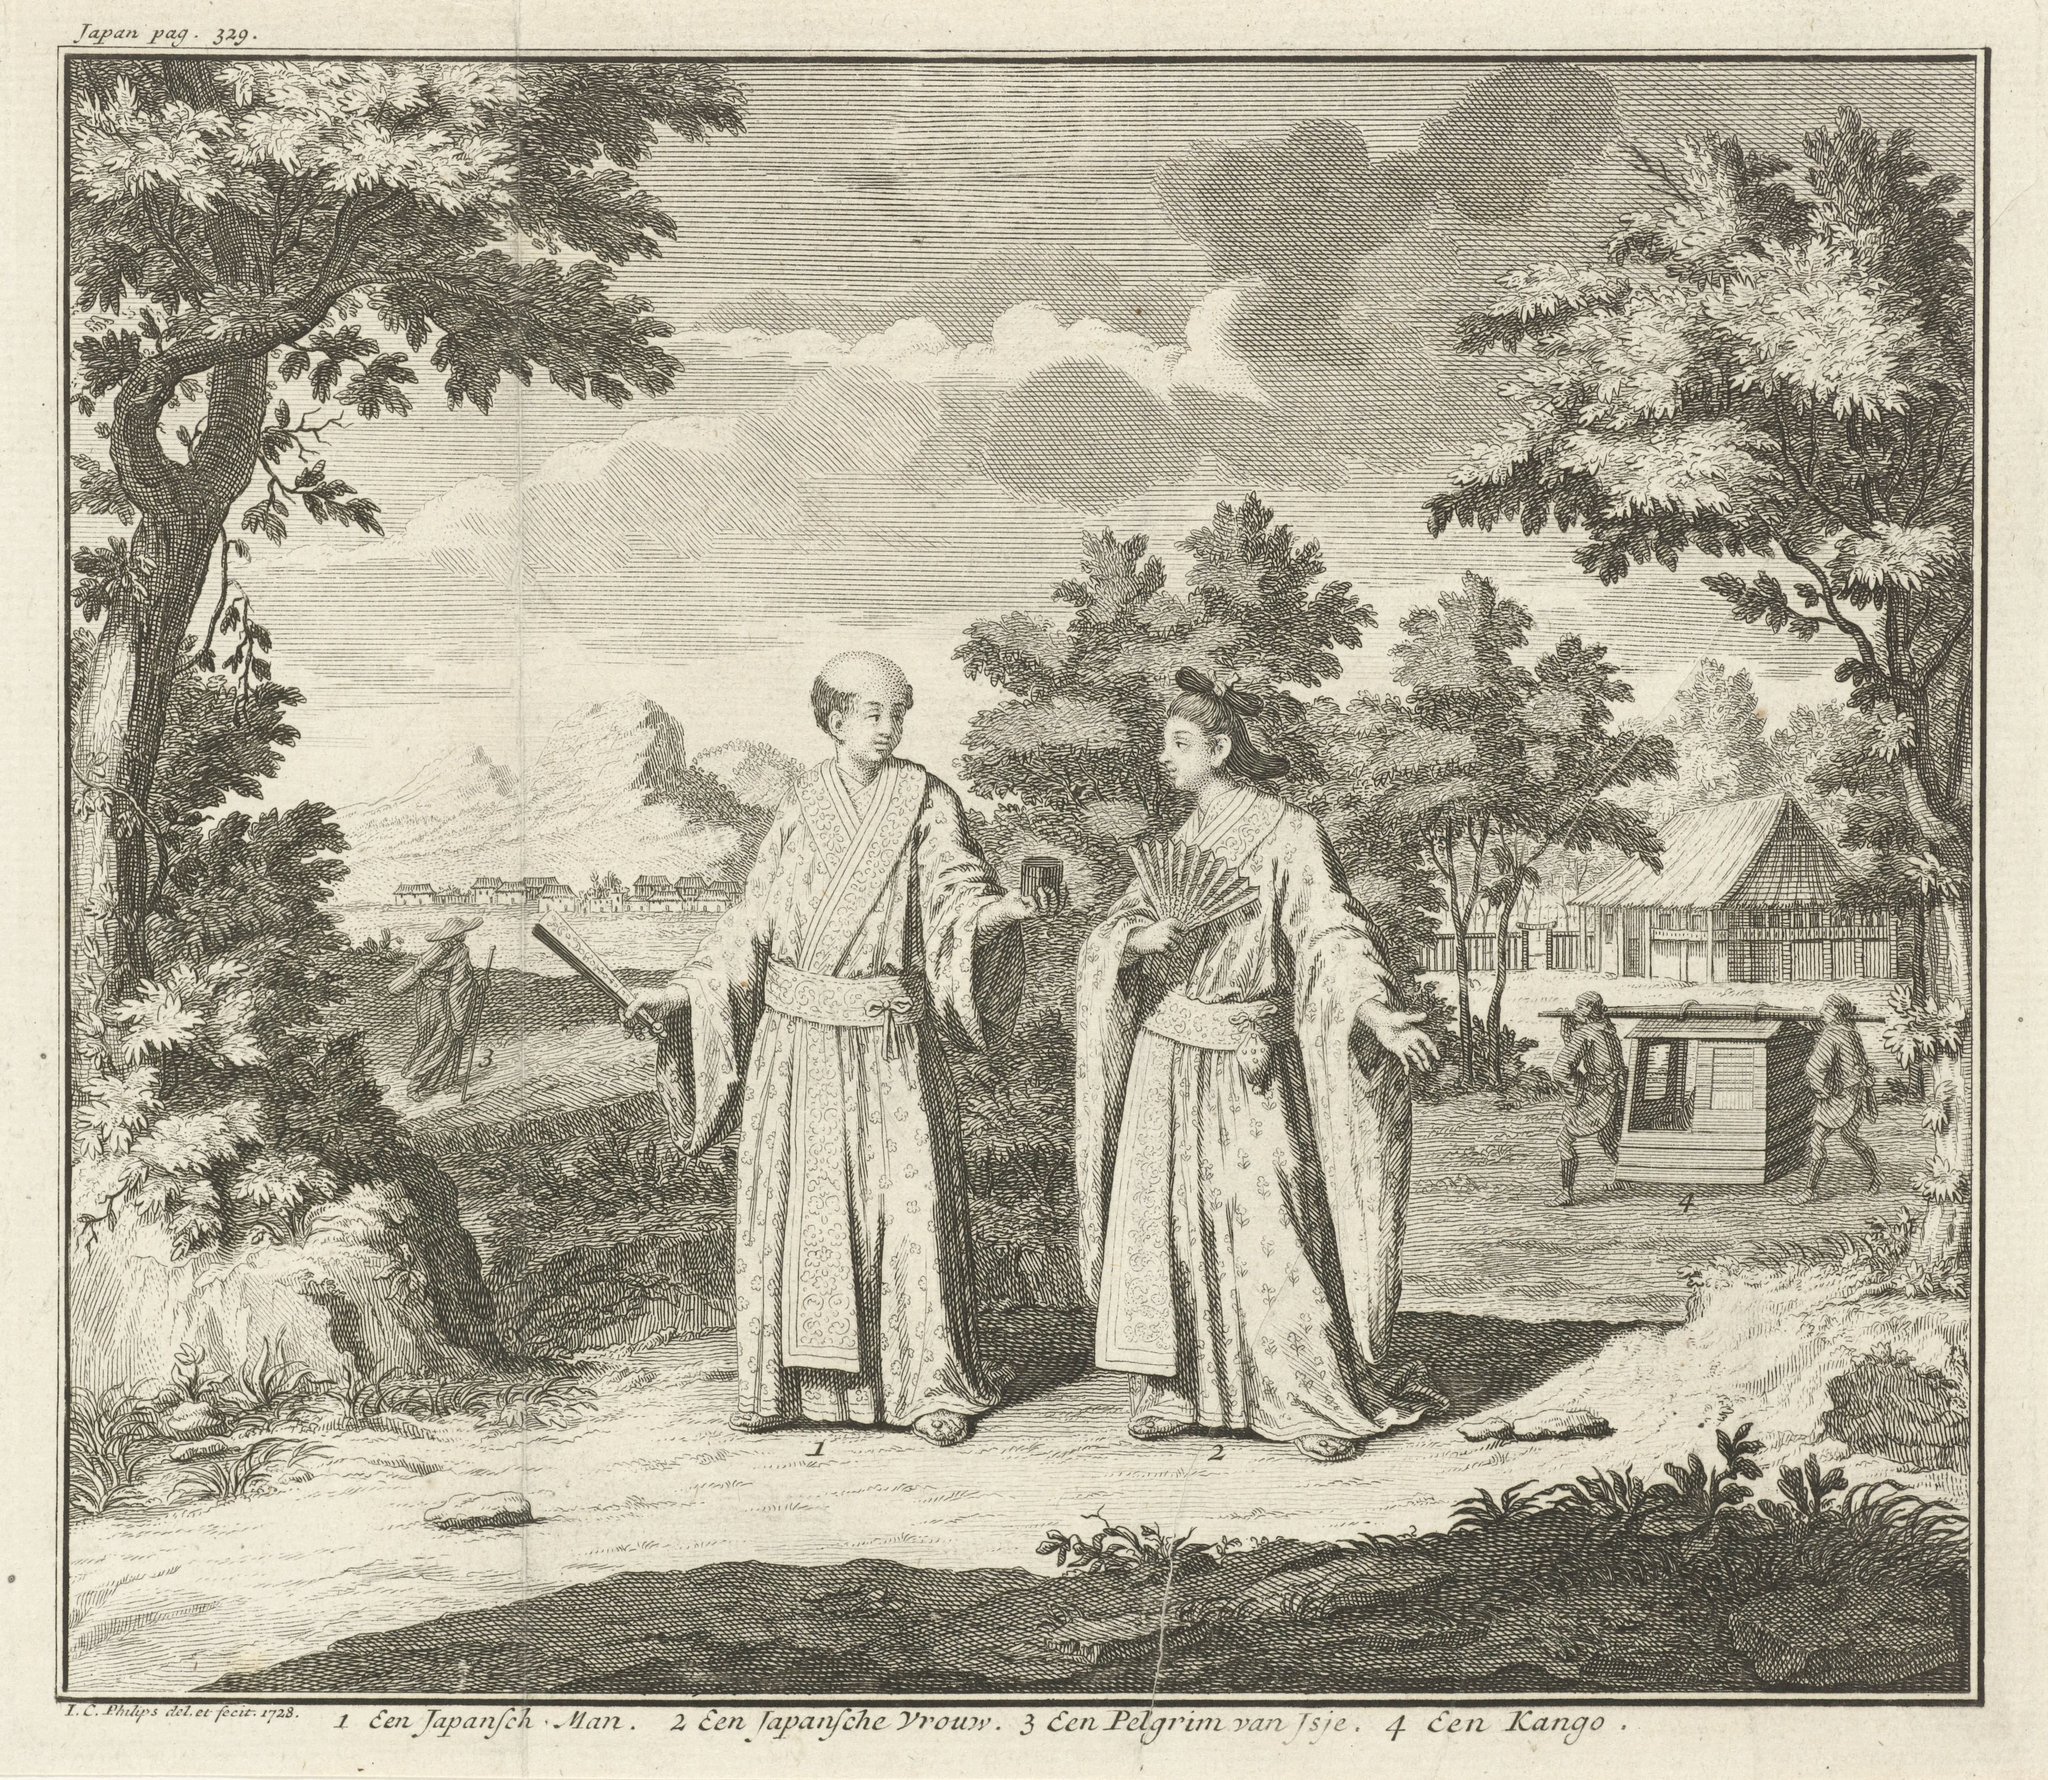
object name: book illustration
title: Landschap met een Japans paar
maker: jan caspar philips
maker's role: draughtsman, print maker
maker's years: 1700-1775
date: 1728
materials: paper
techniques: engraving, etching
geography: amsterdam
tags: rickshaw, japanese, 'en route', traveller under way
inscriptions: collector's mark: Lugt 2228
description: Illustratie uit: Salmon, Thomas.Hedendaegsche historie, of Tegenwoordige staet van alle volkeren (...). I. deel. Behelzende de (...) keizerryken China en Japan. [Vertaald uit het Engels door] M. van Goch. Amsterdam: Isaak Tirion, 1728.